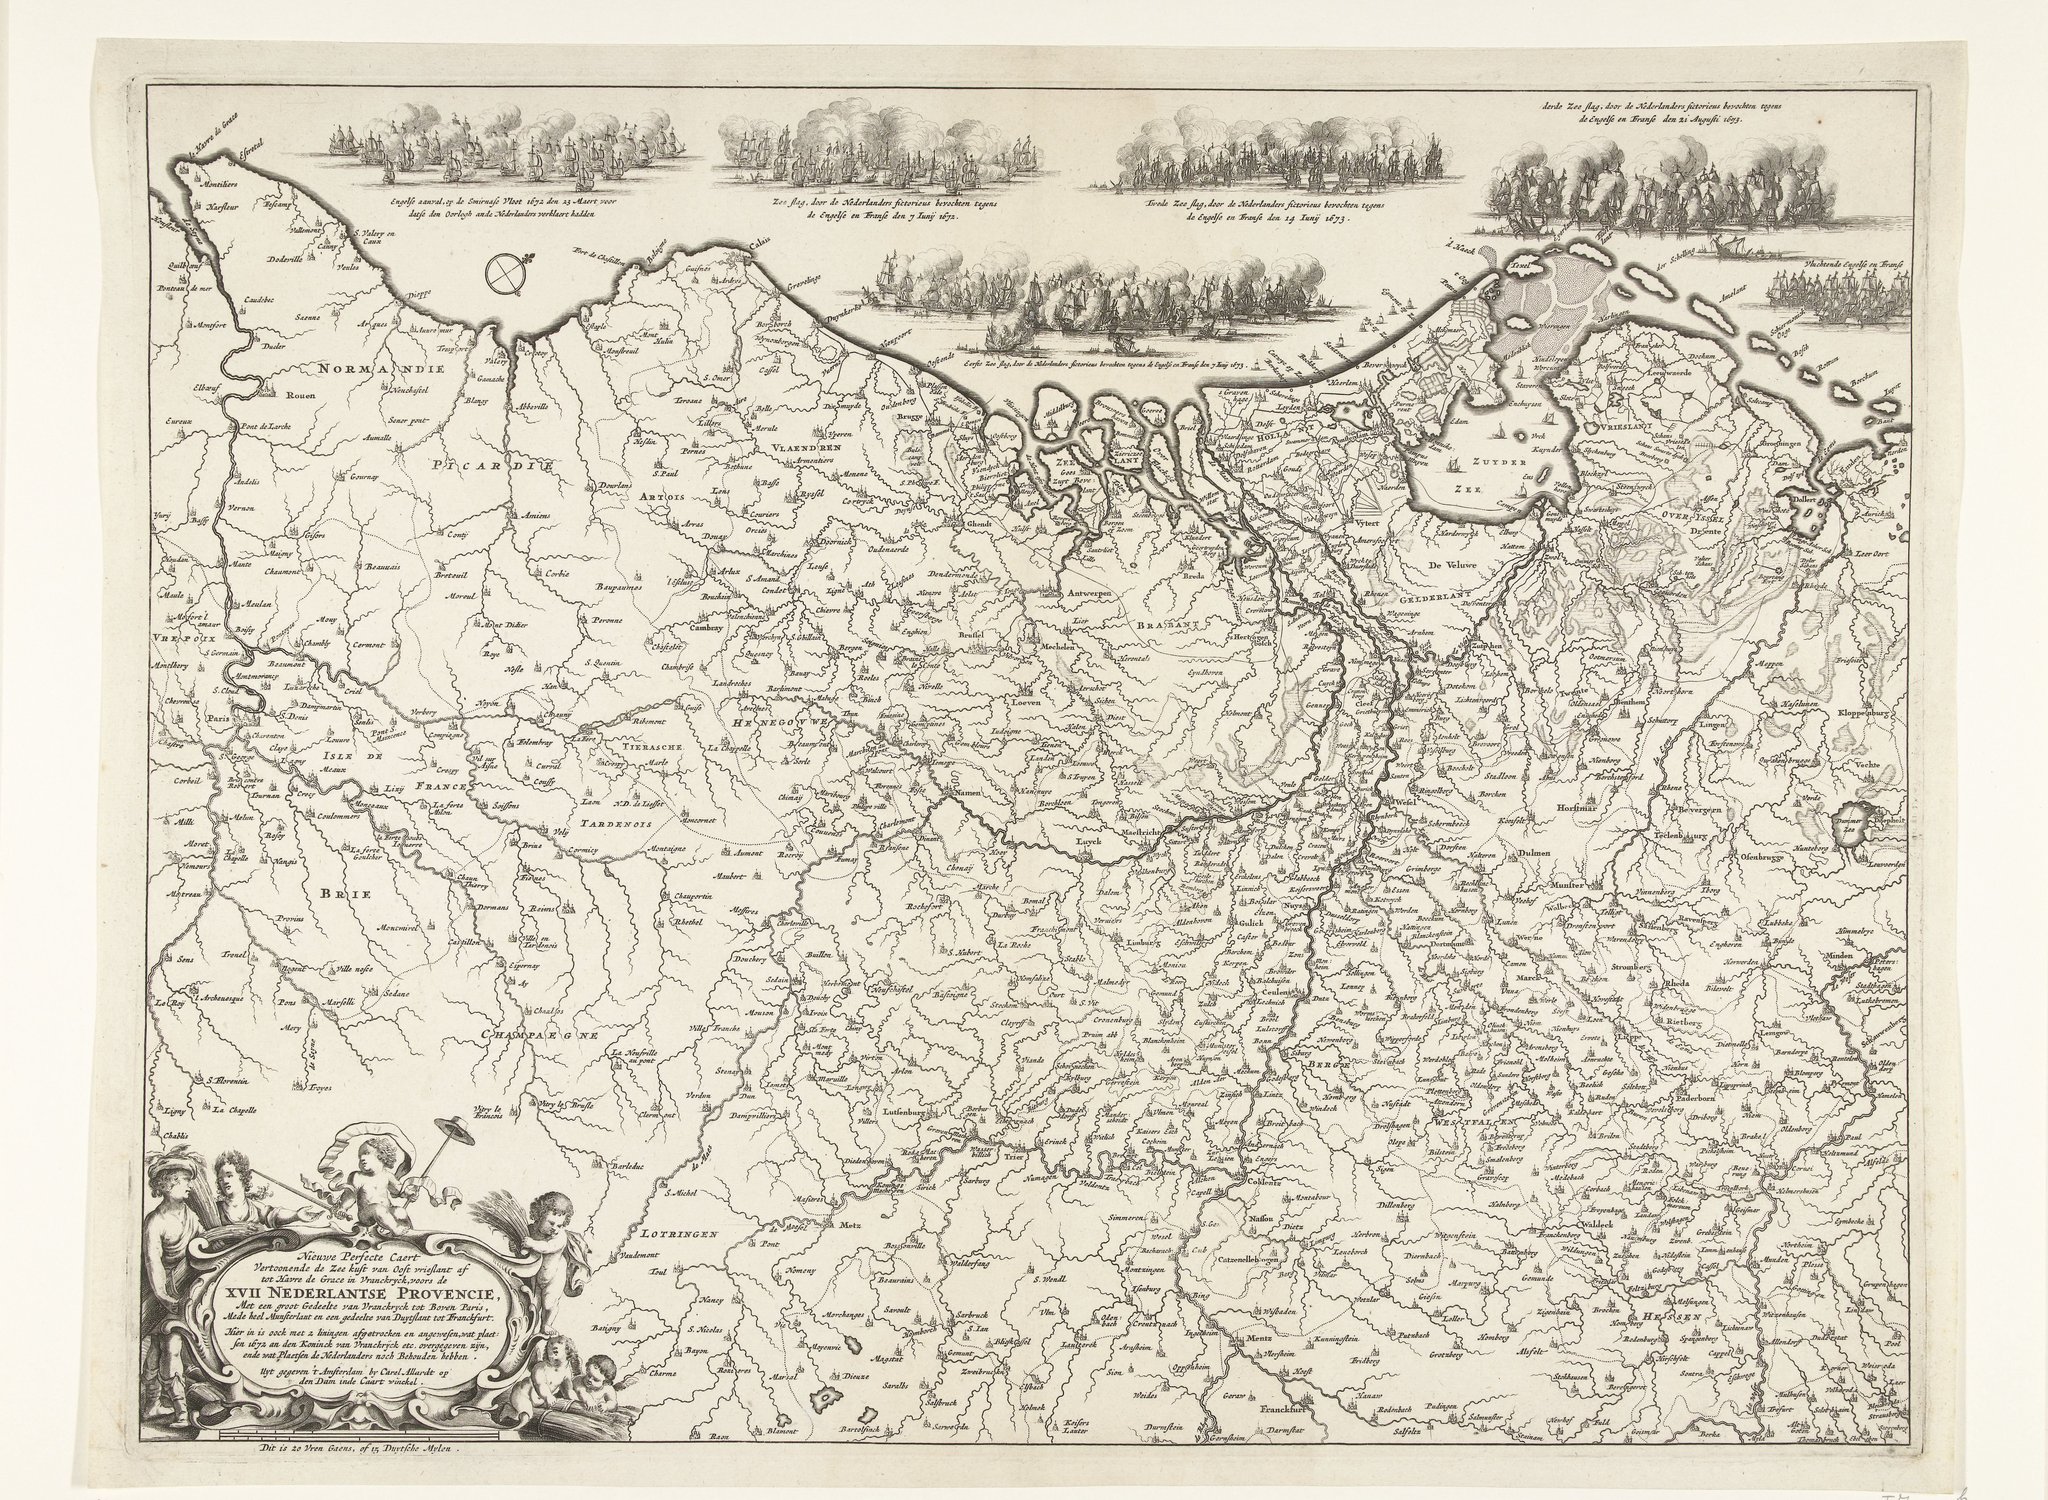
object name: print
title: Kaart van de Nederlanden waarop is aangegeven tot waar de vijandelijke troepen in de jaren 1672-73 zijn opgerukt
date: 1673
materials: paper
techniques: etching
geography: amsterdam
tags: maps of separate countries or regions, netherlands, rampjaar (disaster year)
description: Kaart van de Nederlanden waarop is aangegeven tot hoever de Franse en bisschoppelijke legers in 1672 zijn opgerukt. Boven de kaart in zee zijn de zeeslagen uit de jaren 1672-1673 voorgesteld. Linksonder de cartouche met de titel van de kaart.